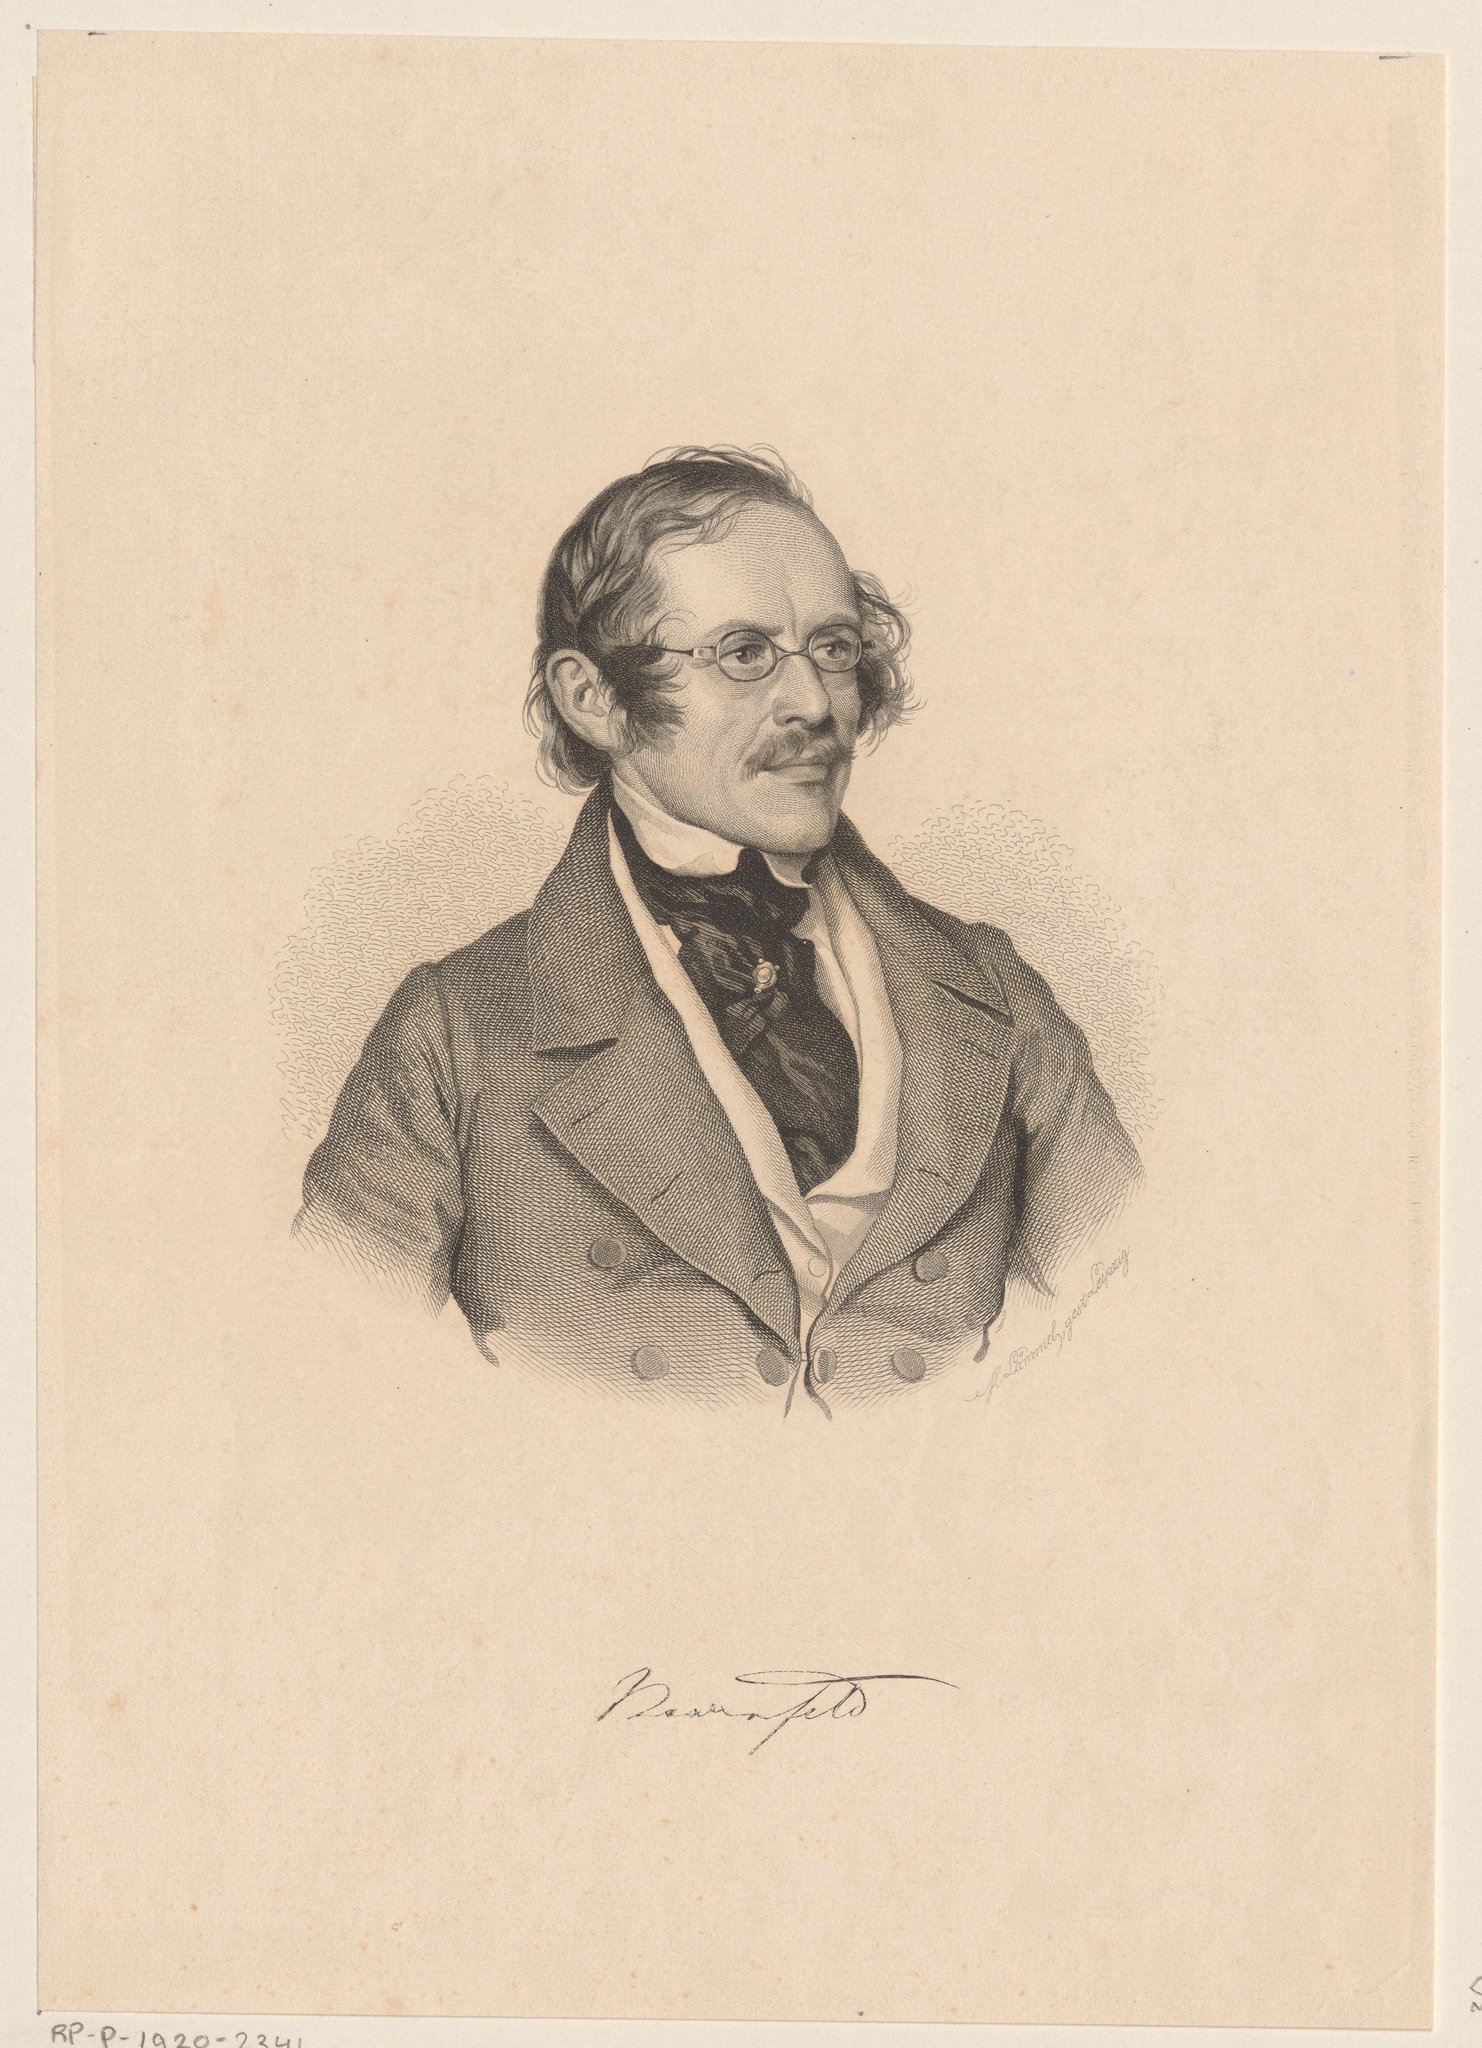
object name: print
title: Portret van Eduard von Bauernfeld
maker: moritz lämmel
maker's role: print maker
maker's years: 1822-1866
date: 1832-1866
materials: paper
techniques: engraving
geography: leipzig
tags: vienna, vienna state, historical persons, writer, poet, author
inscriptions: collector's mark: Lugt 2228